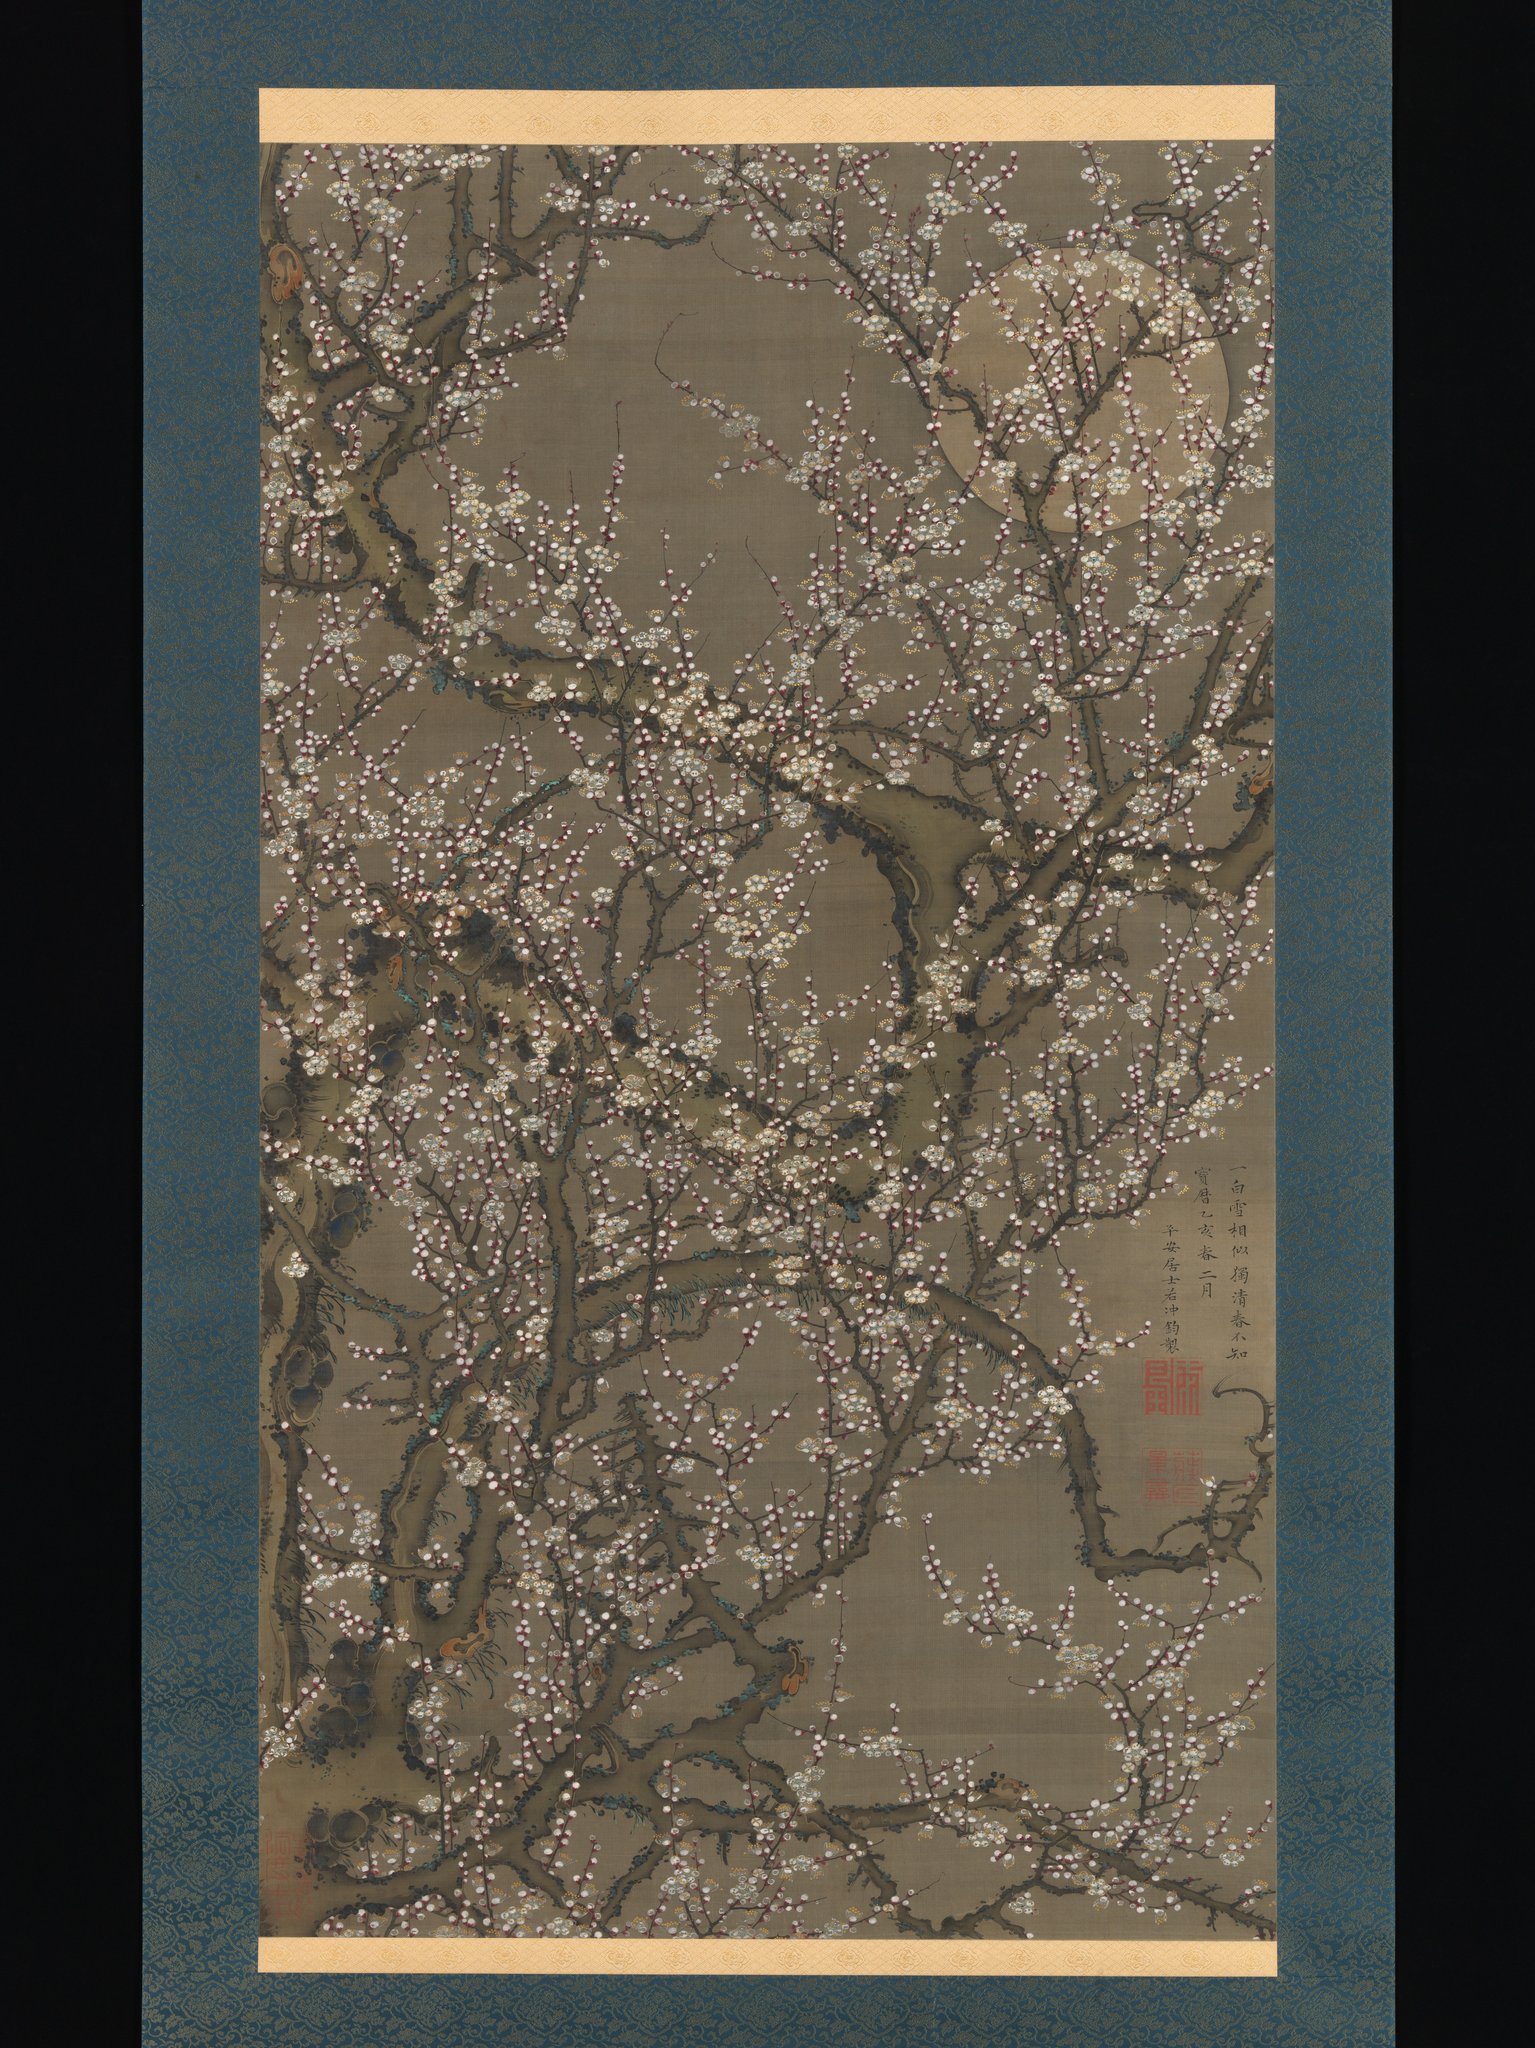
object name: hanging scroll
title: White Plum Blossoms and Moon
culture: japanese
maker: itō jakuchū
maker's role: artist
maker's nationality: japanese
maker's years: 1716-1800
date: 1755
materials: ink, silk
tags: flowers,trees